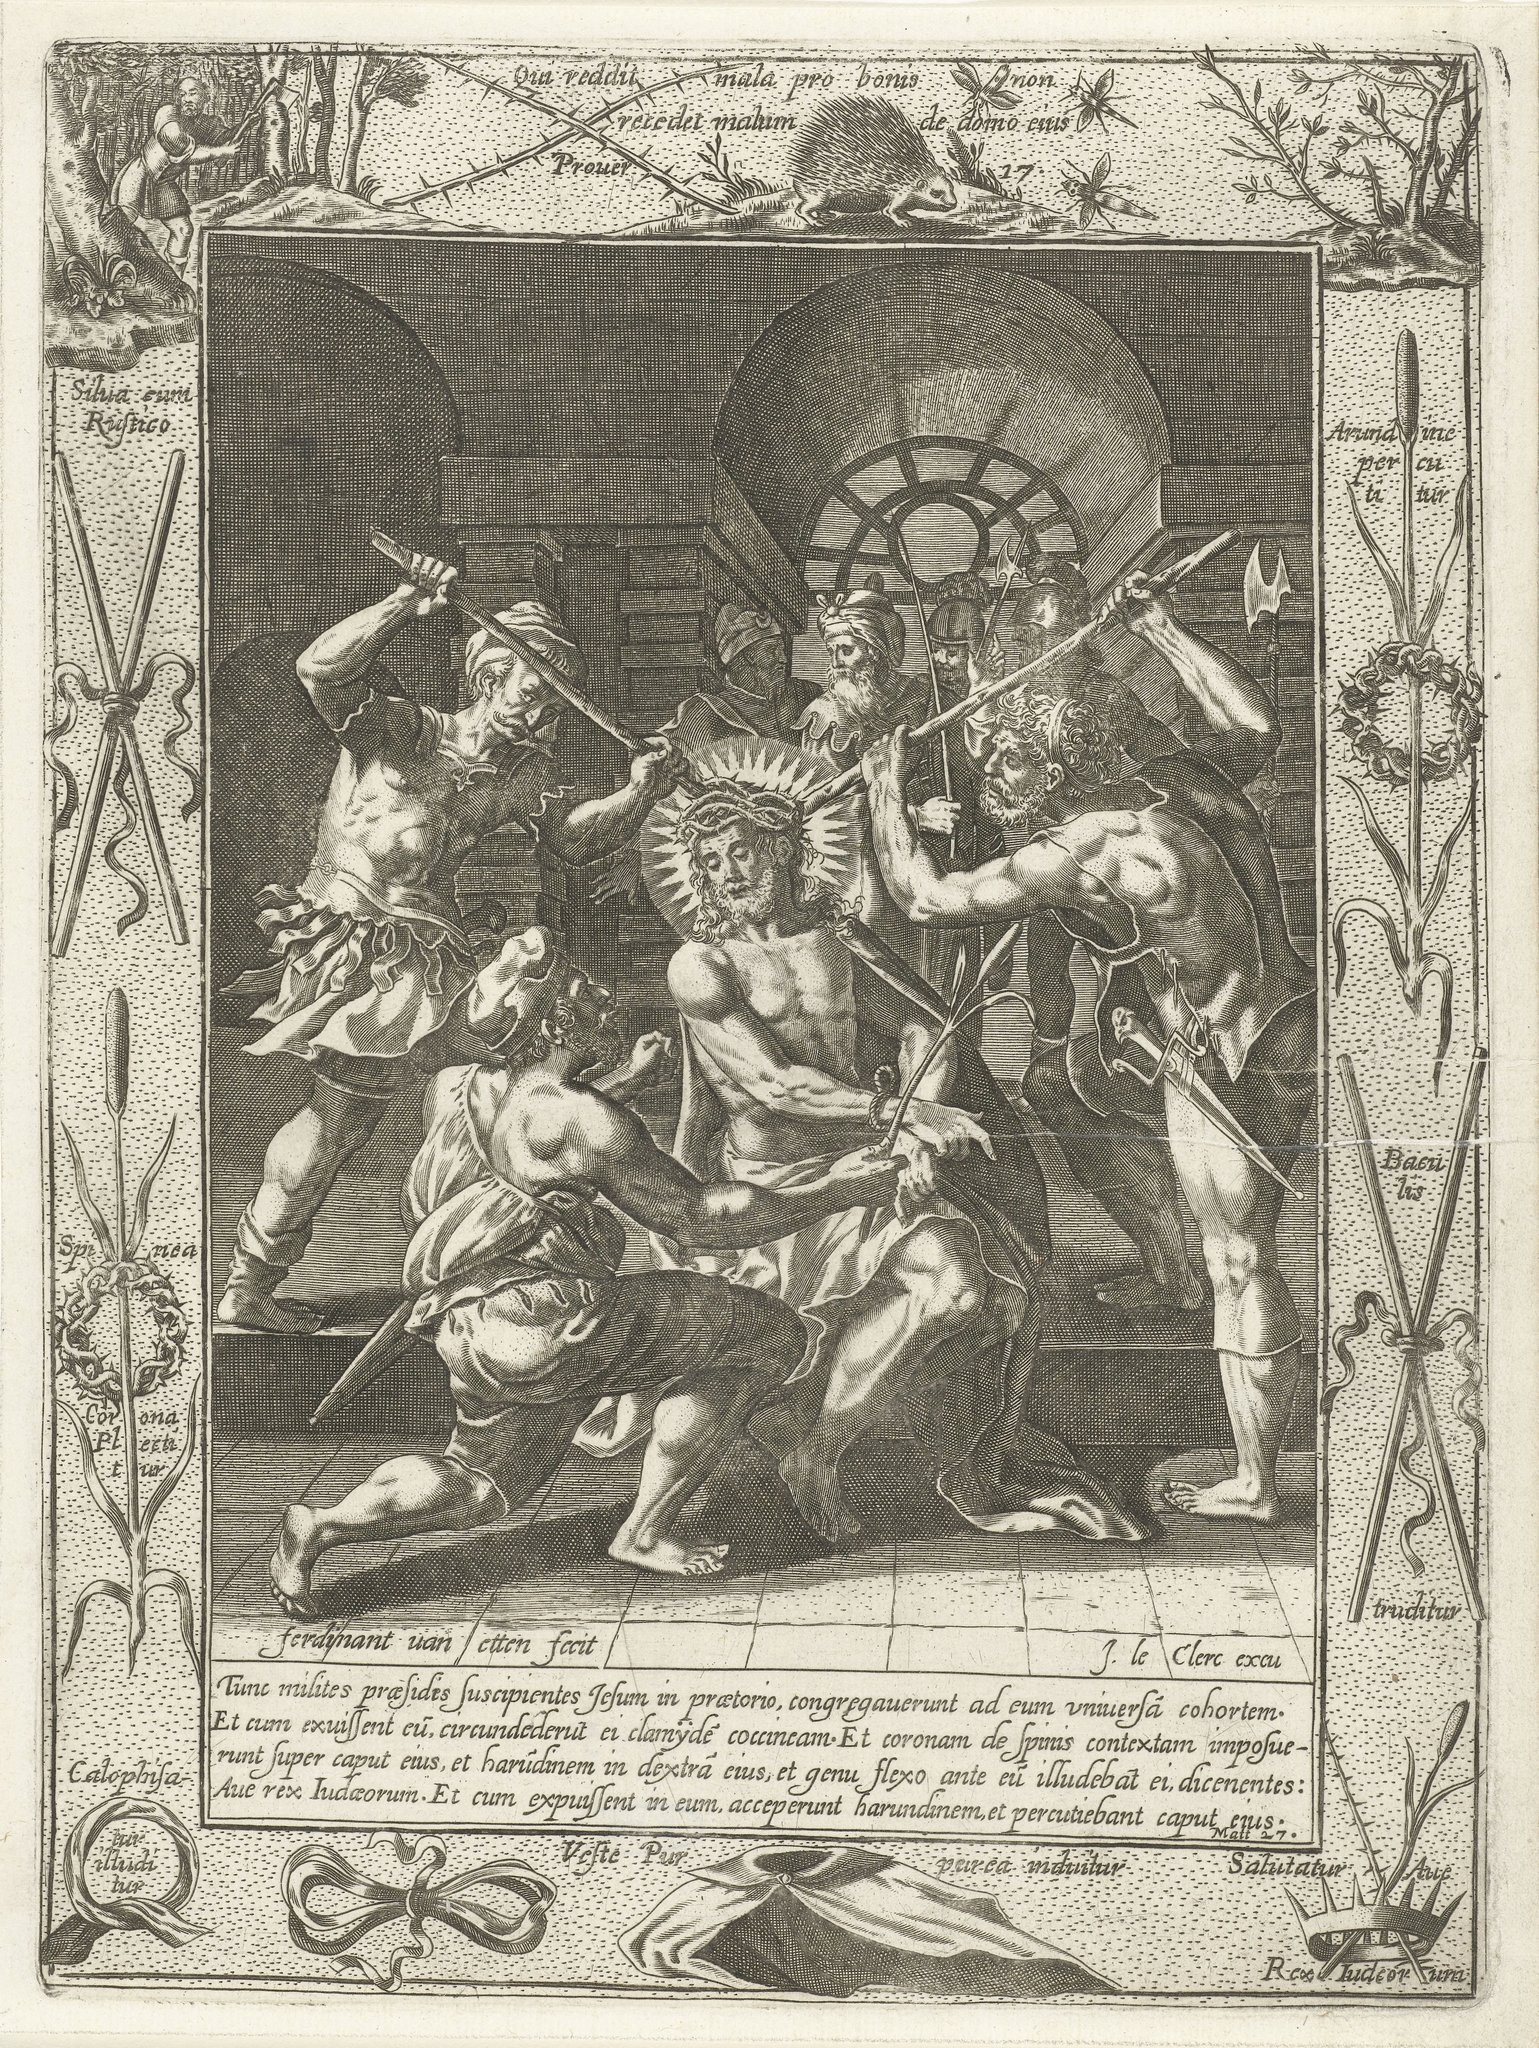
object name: print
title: Christus in het huis van Pilatus bespot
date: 1605-1700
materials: paper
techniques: engraving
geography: low countries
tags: in pilate's palace christ is mocked by soldiers (luke 22:63-65)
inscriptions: collector's mark: Lugt 2228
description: Christus gezeten, de handen gebonden, wordt door twee krijgsknechten met stokken geslagen. Een derde zit geknield vóór Christus en bespot hem. Op de achtergrond Pilatus en soldaten. Onder de voorstelling een vierregelig onderschrift in Latijn (Mat. 27). Het geheel is omgeven door een randlijst waarop de passieinstrumenten.